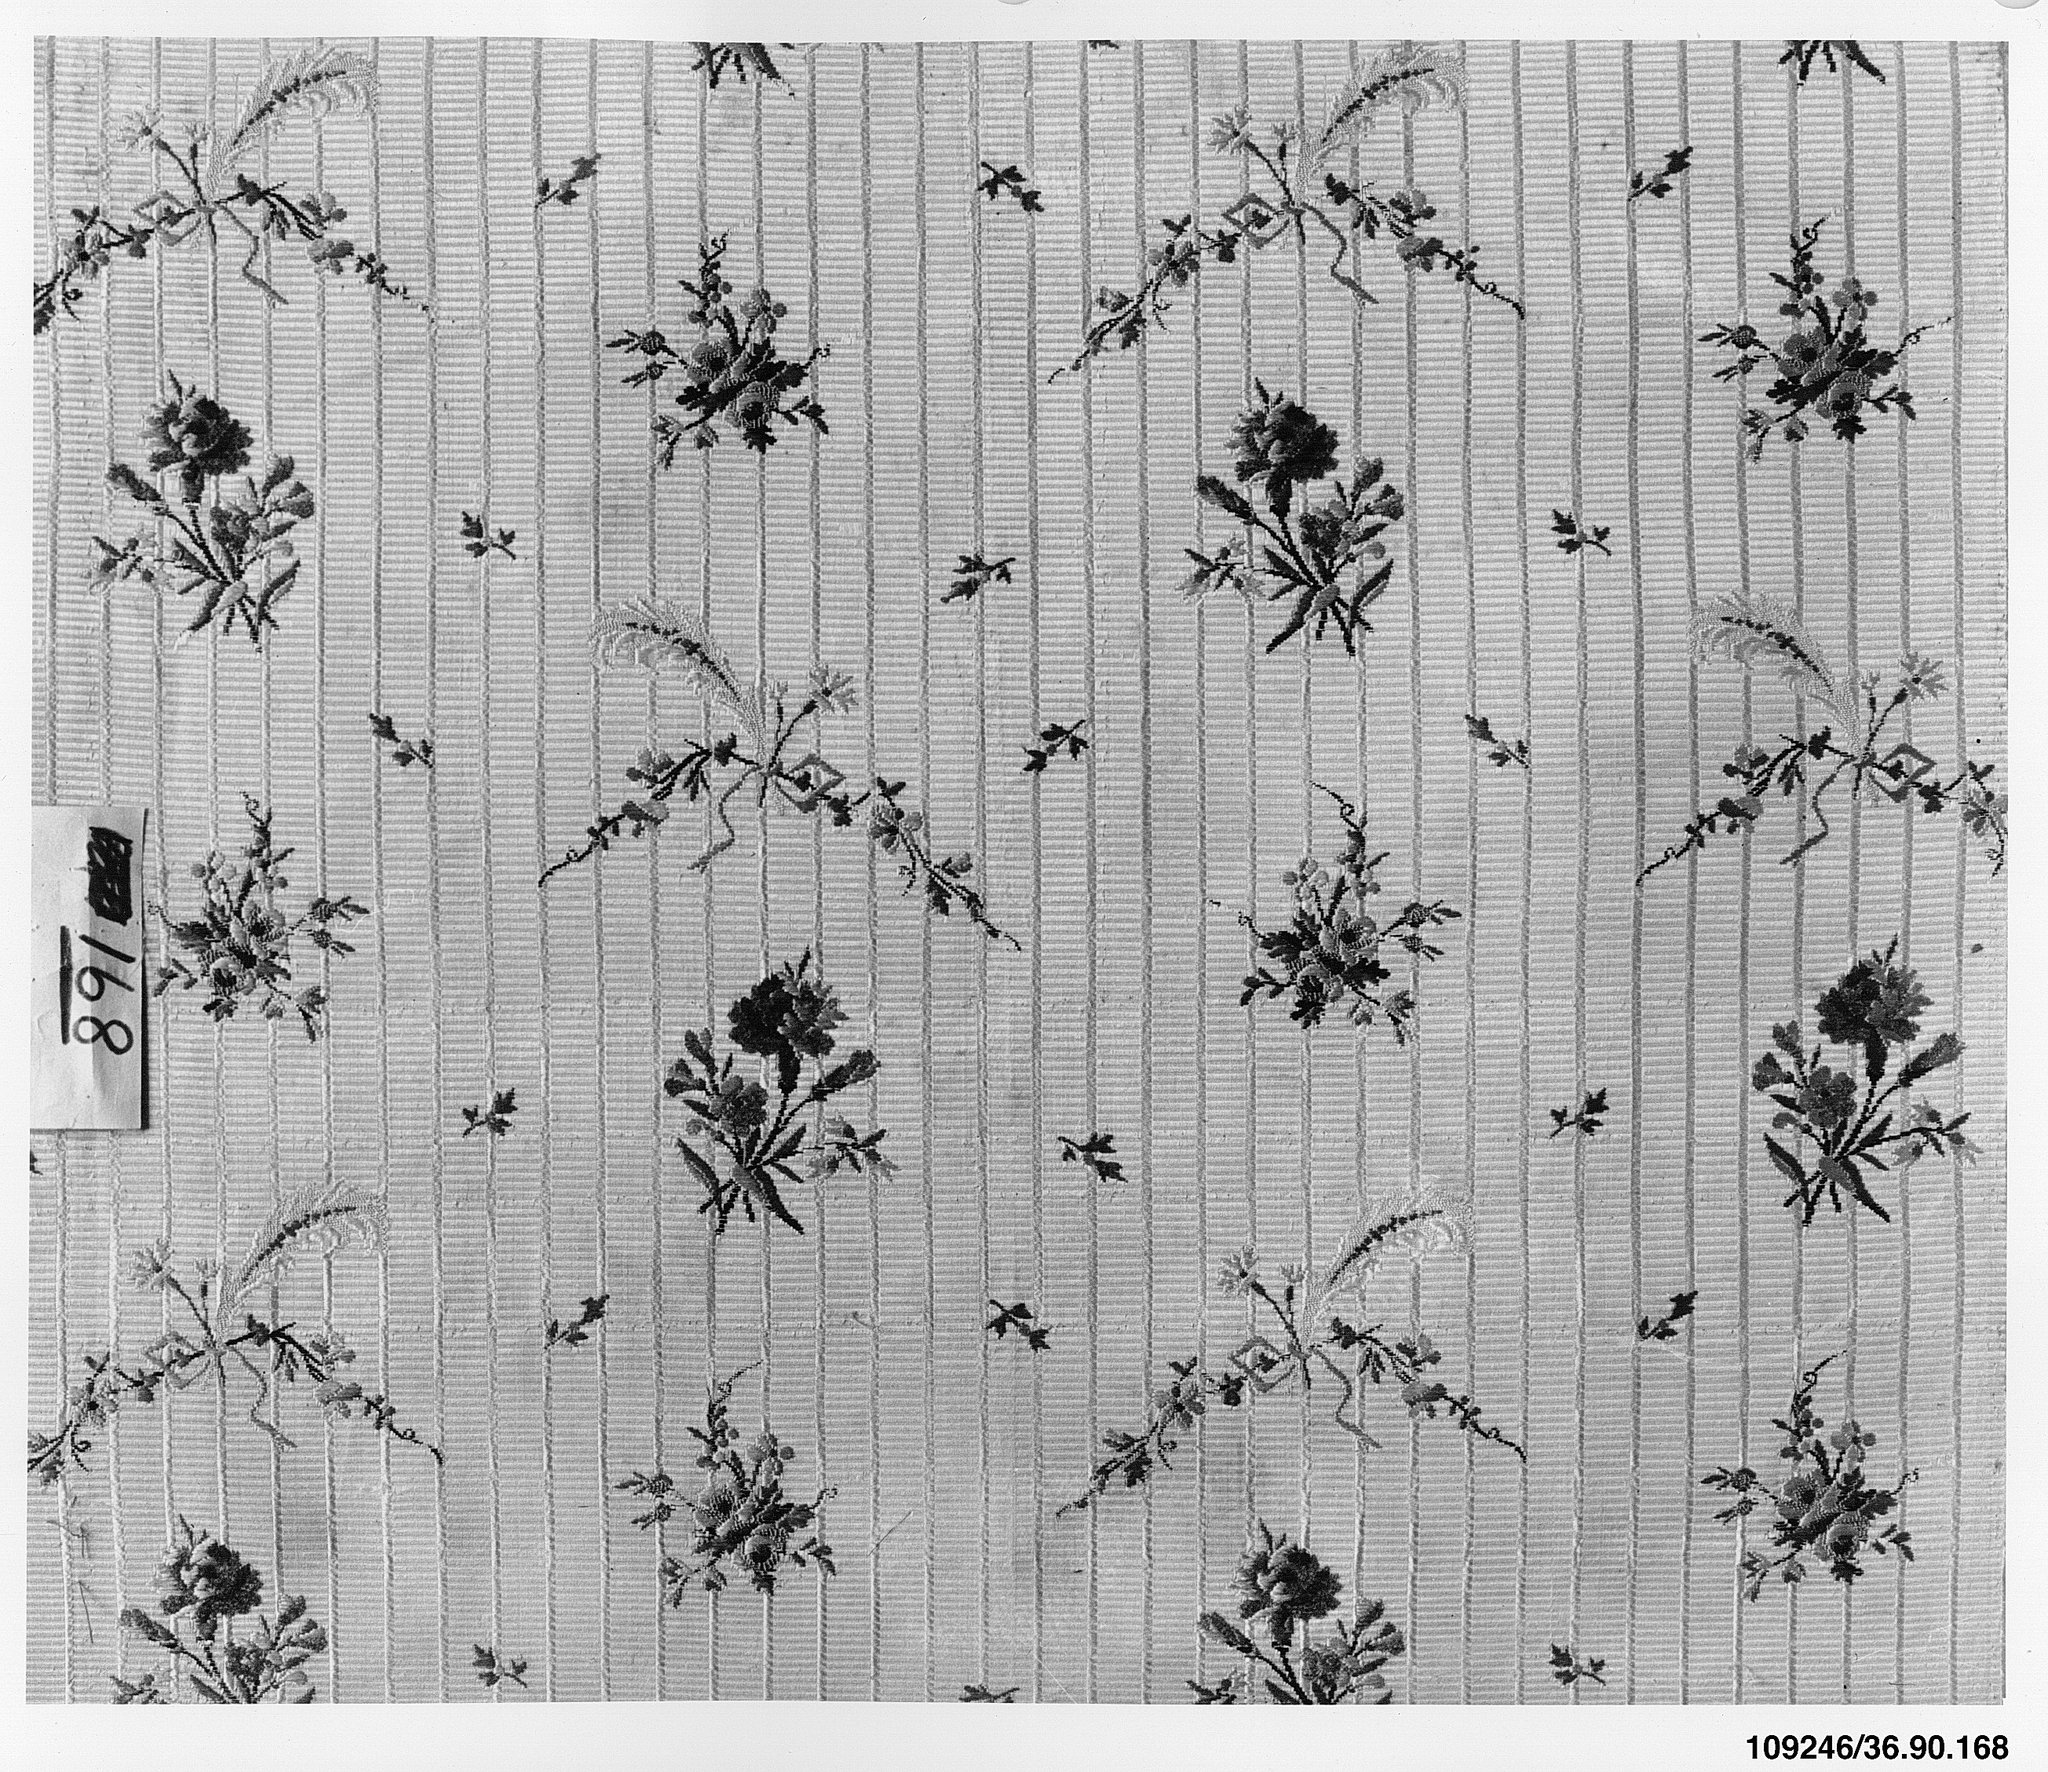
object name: piece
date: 1701-1800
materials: silk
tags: flowers